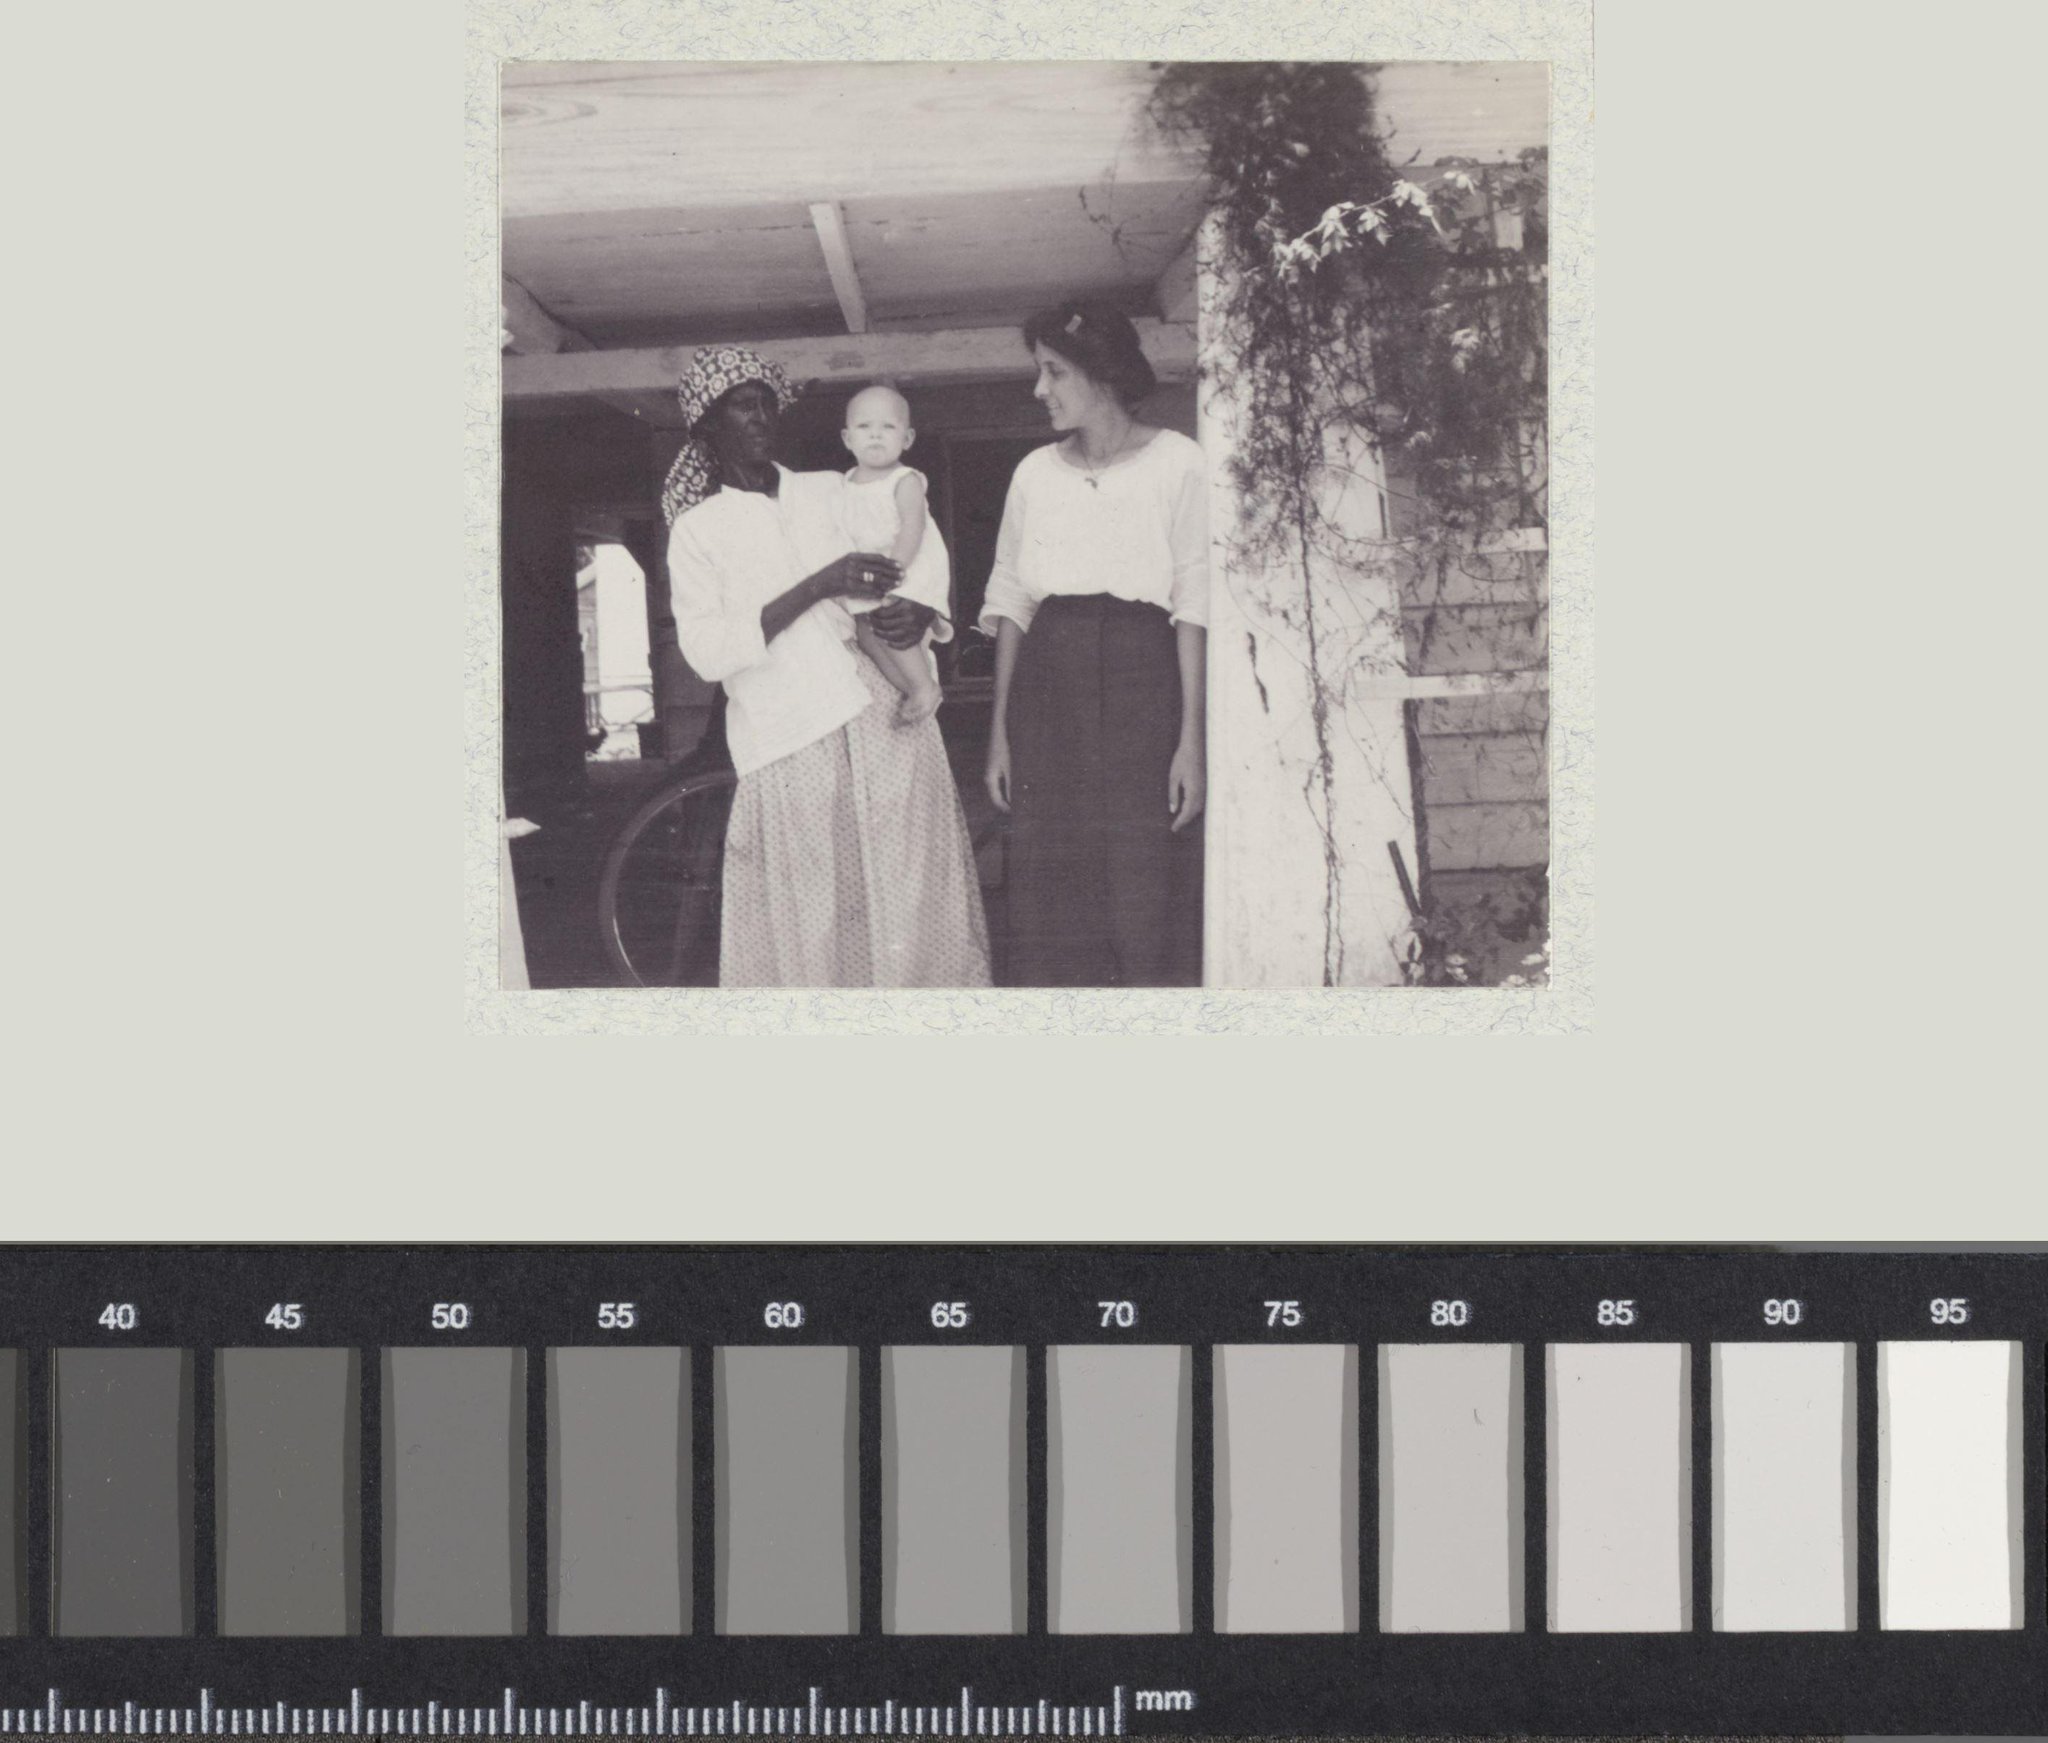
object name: photograph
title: Maria Gonggrijp met kind en kinderverzorgster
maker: Anonymous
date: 1911-1912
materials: photographic support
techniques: photography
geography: suriname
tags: maid ~ house personnel, suriname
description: Maria Gonggrijp staande bij een kinderverzorgster die een kind op de arm draagt. Onderdeel van het fotoalbum van de familie Boom-Gonggrijp in Suriname en Curaçao.